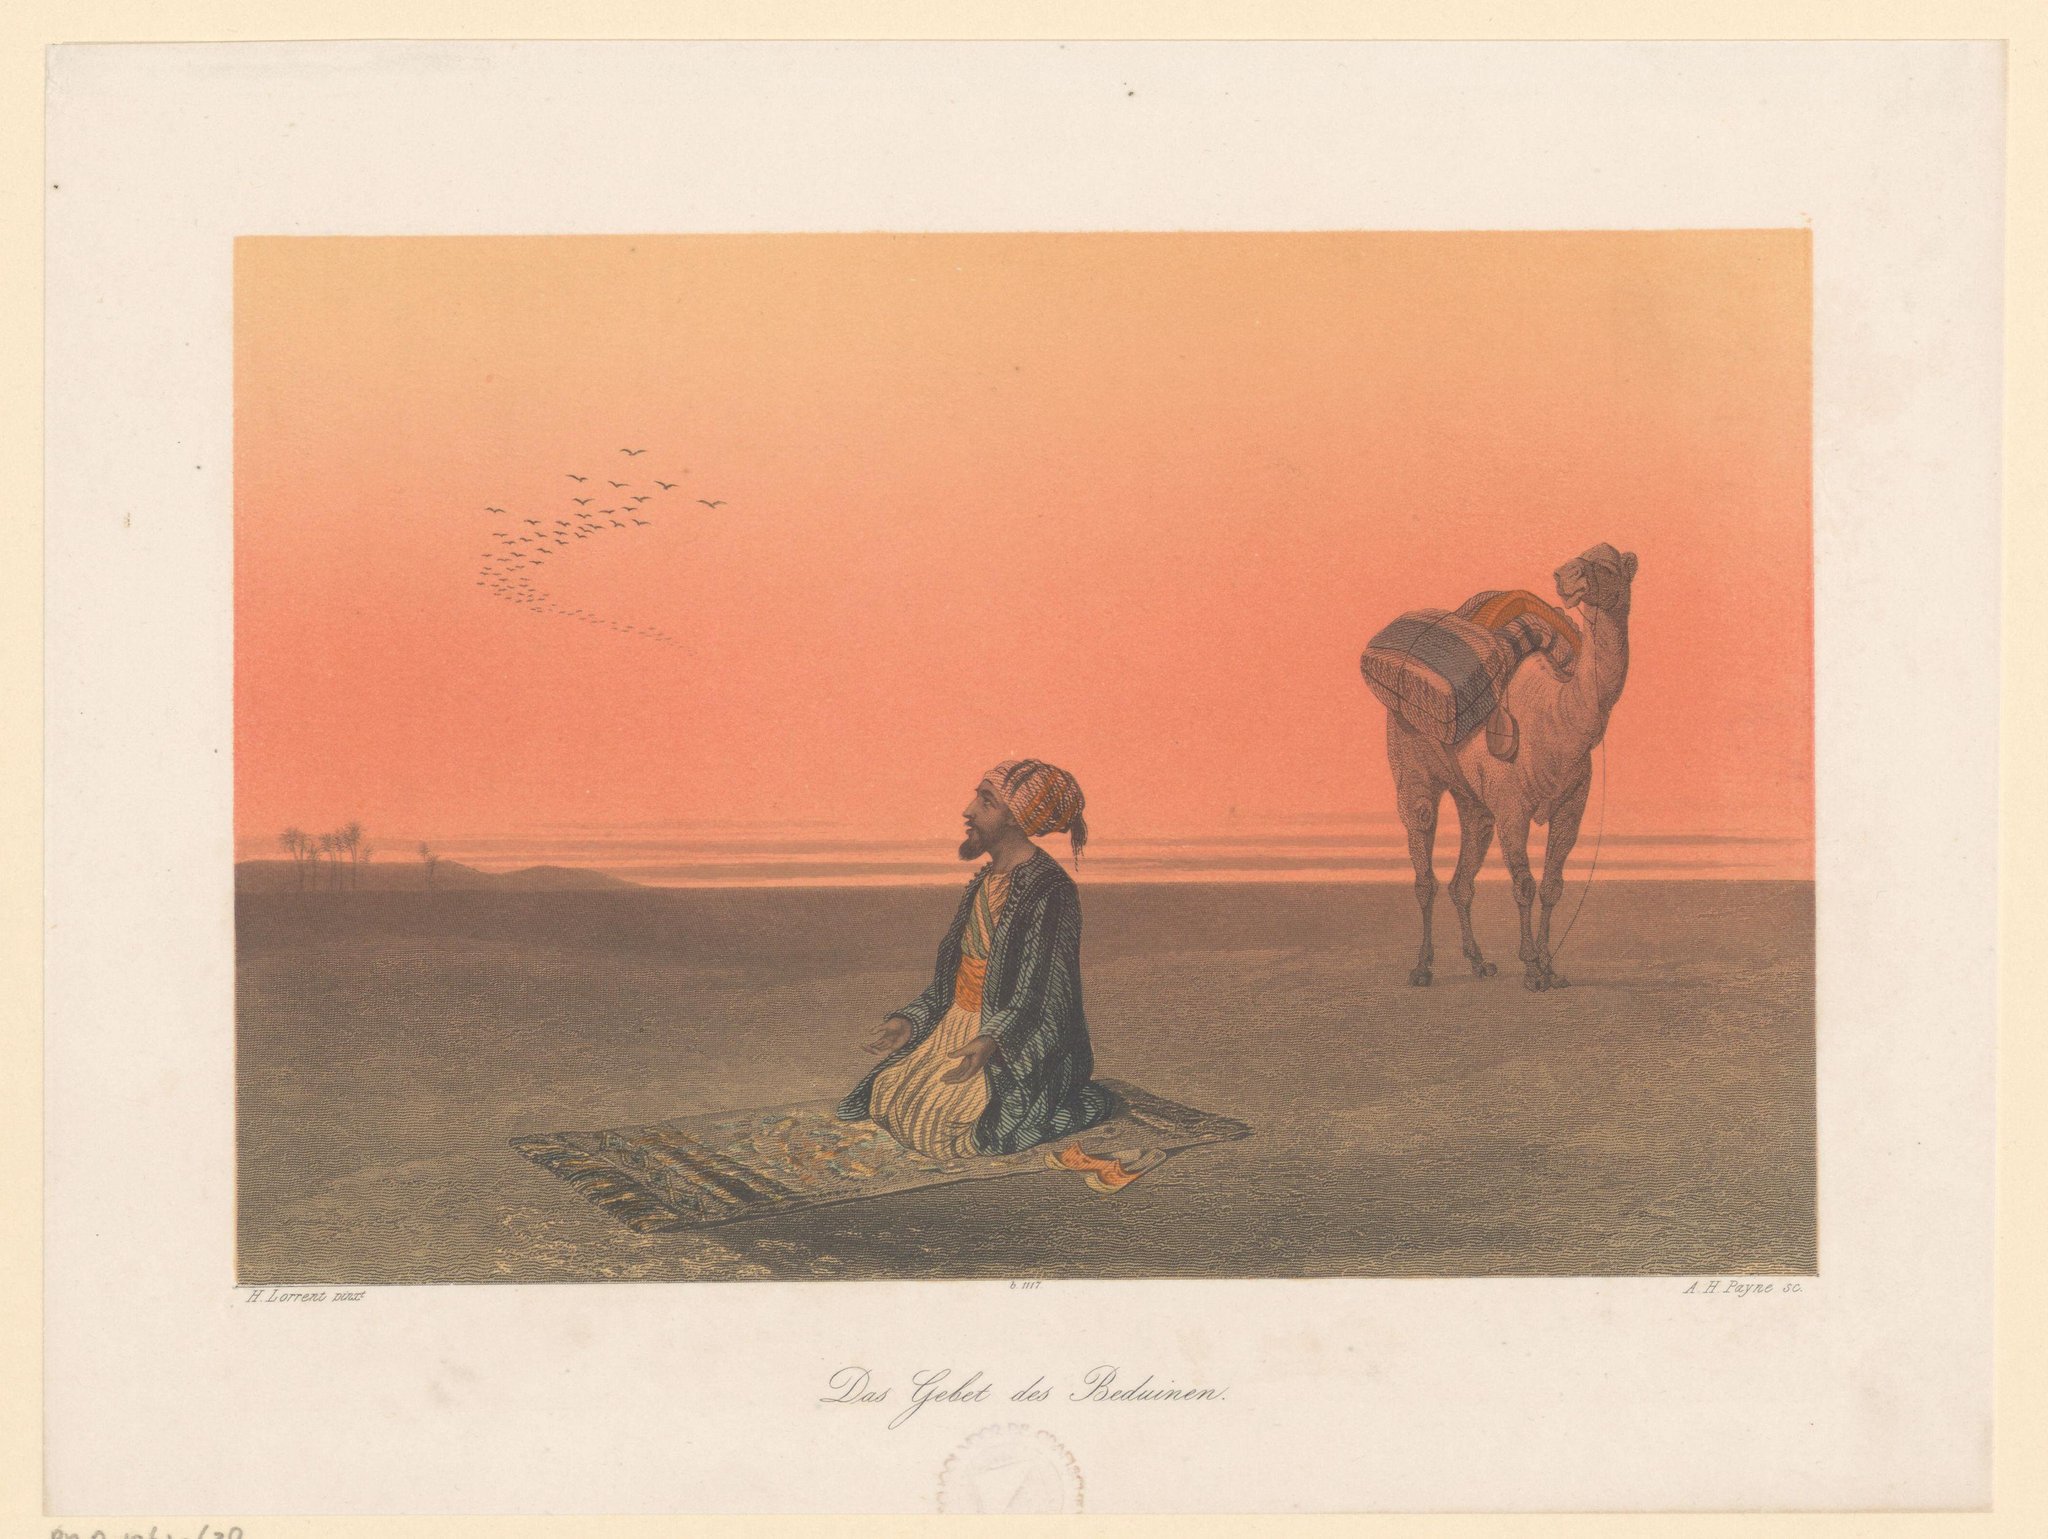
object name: print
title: Das Gebet des Beduinen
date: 1845-1902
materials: paper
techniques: hand coloring, iris print, engraving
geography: leipzig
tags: hoofed animals: camel, africans (bedouins), prayer ~ non-christian religions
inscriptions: stamp: ‘School voor de Grafische [...]’, collector's mark: Lugt 2228